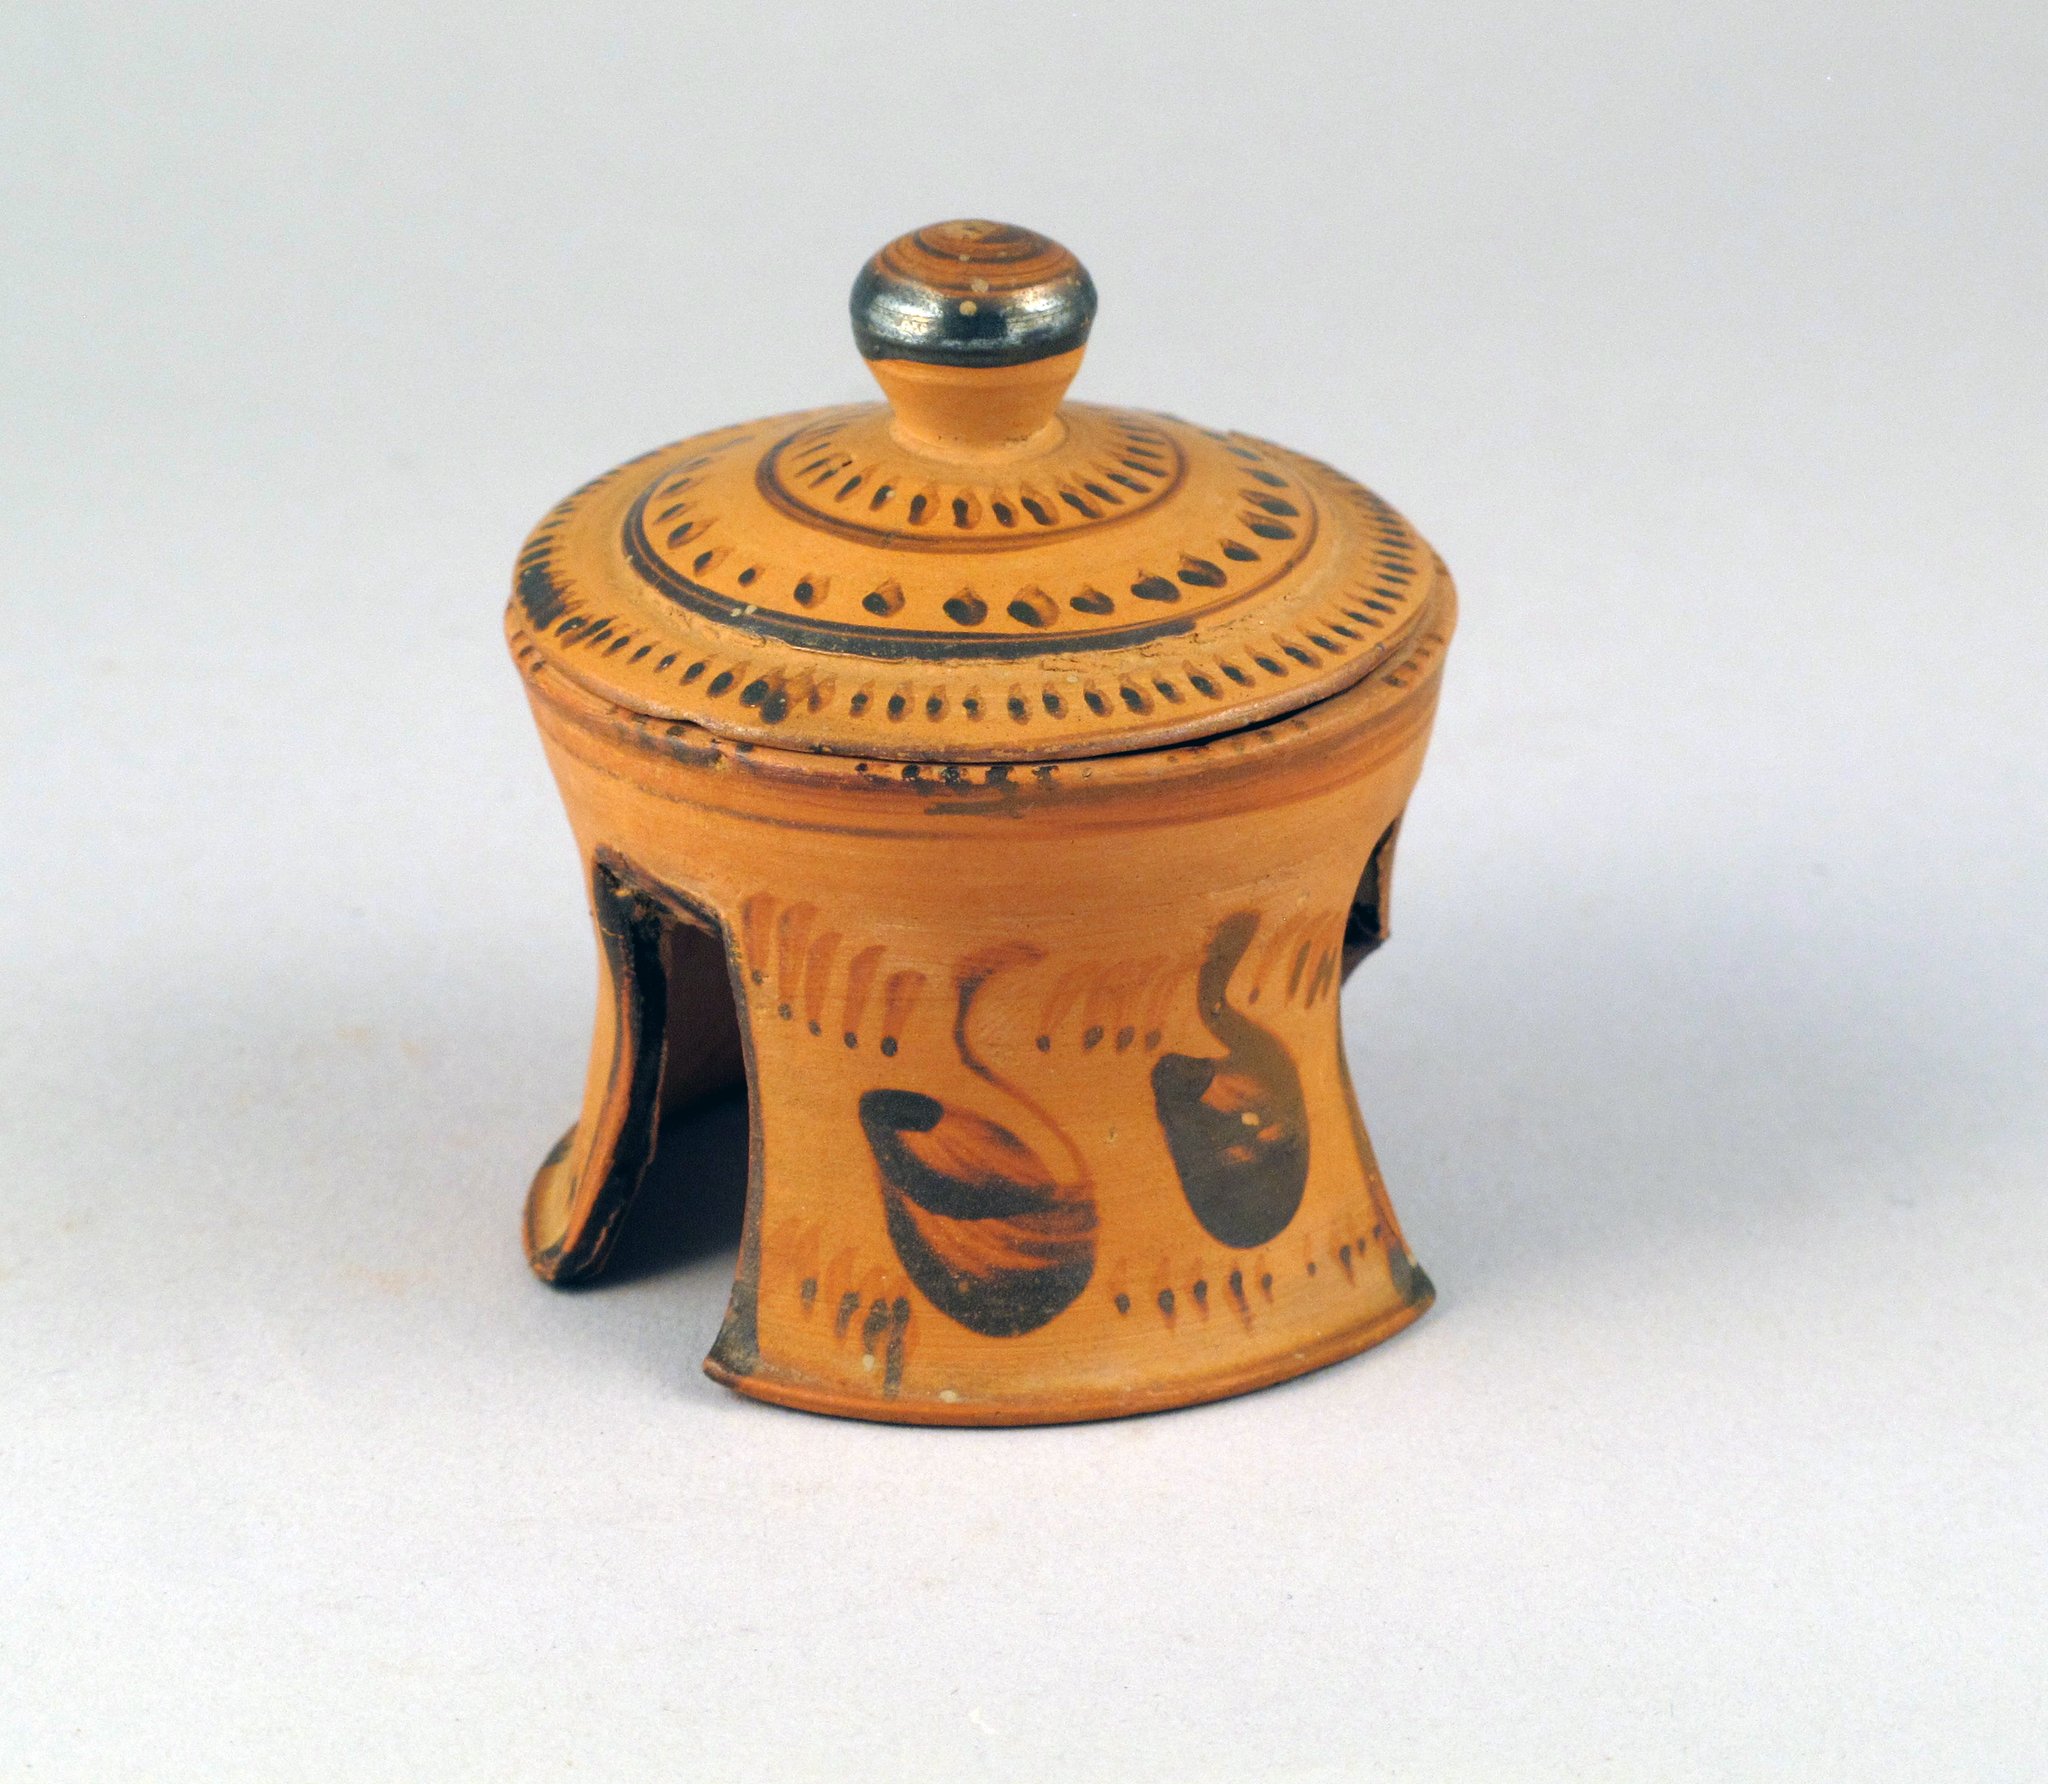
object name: pyxis with lid, miniature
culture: greek, attic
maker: swan group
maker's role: artist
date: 567-535 BCE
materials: terracotta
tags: swans